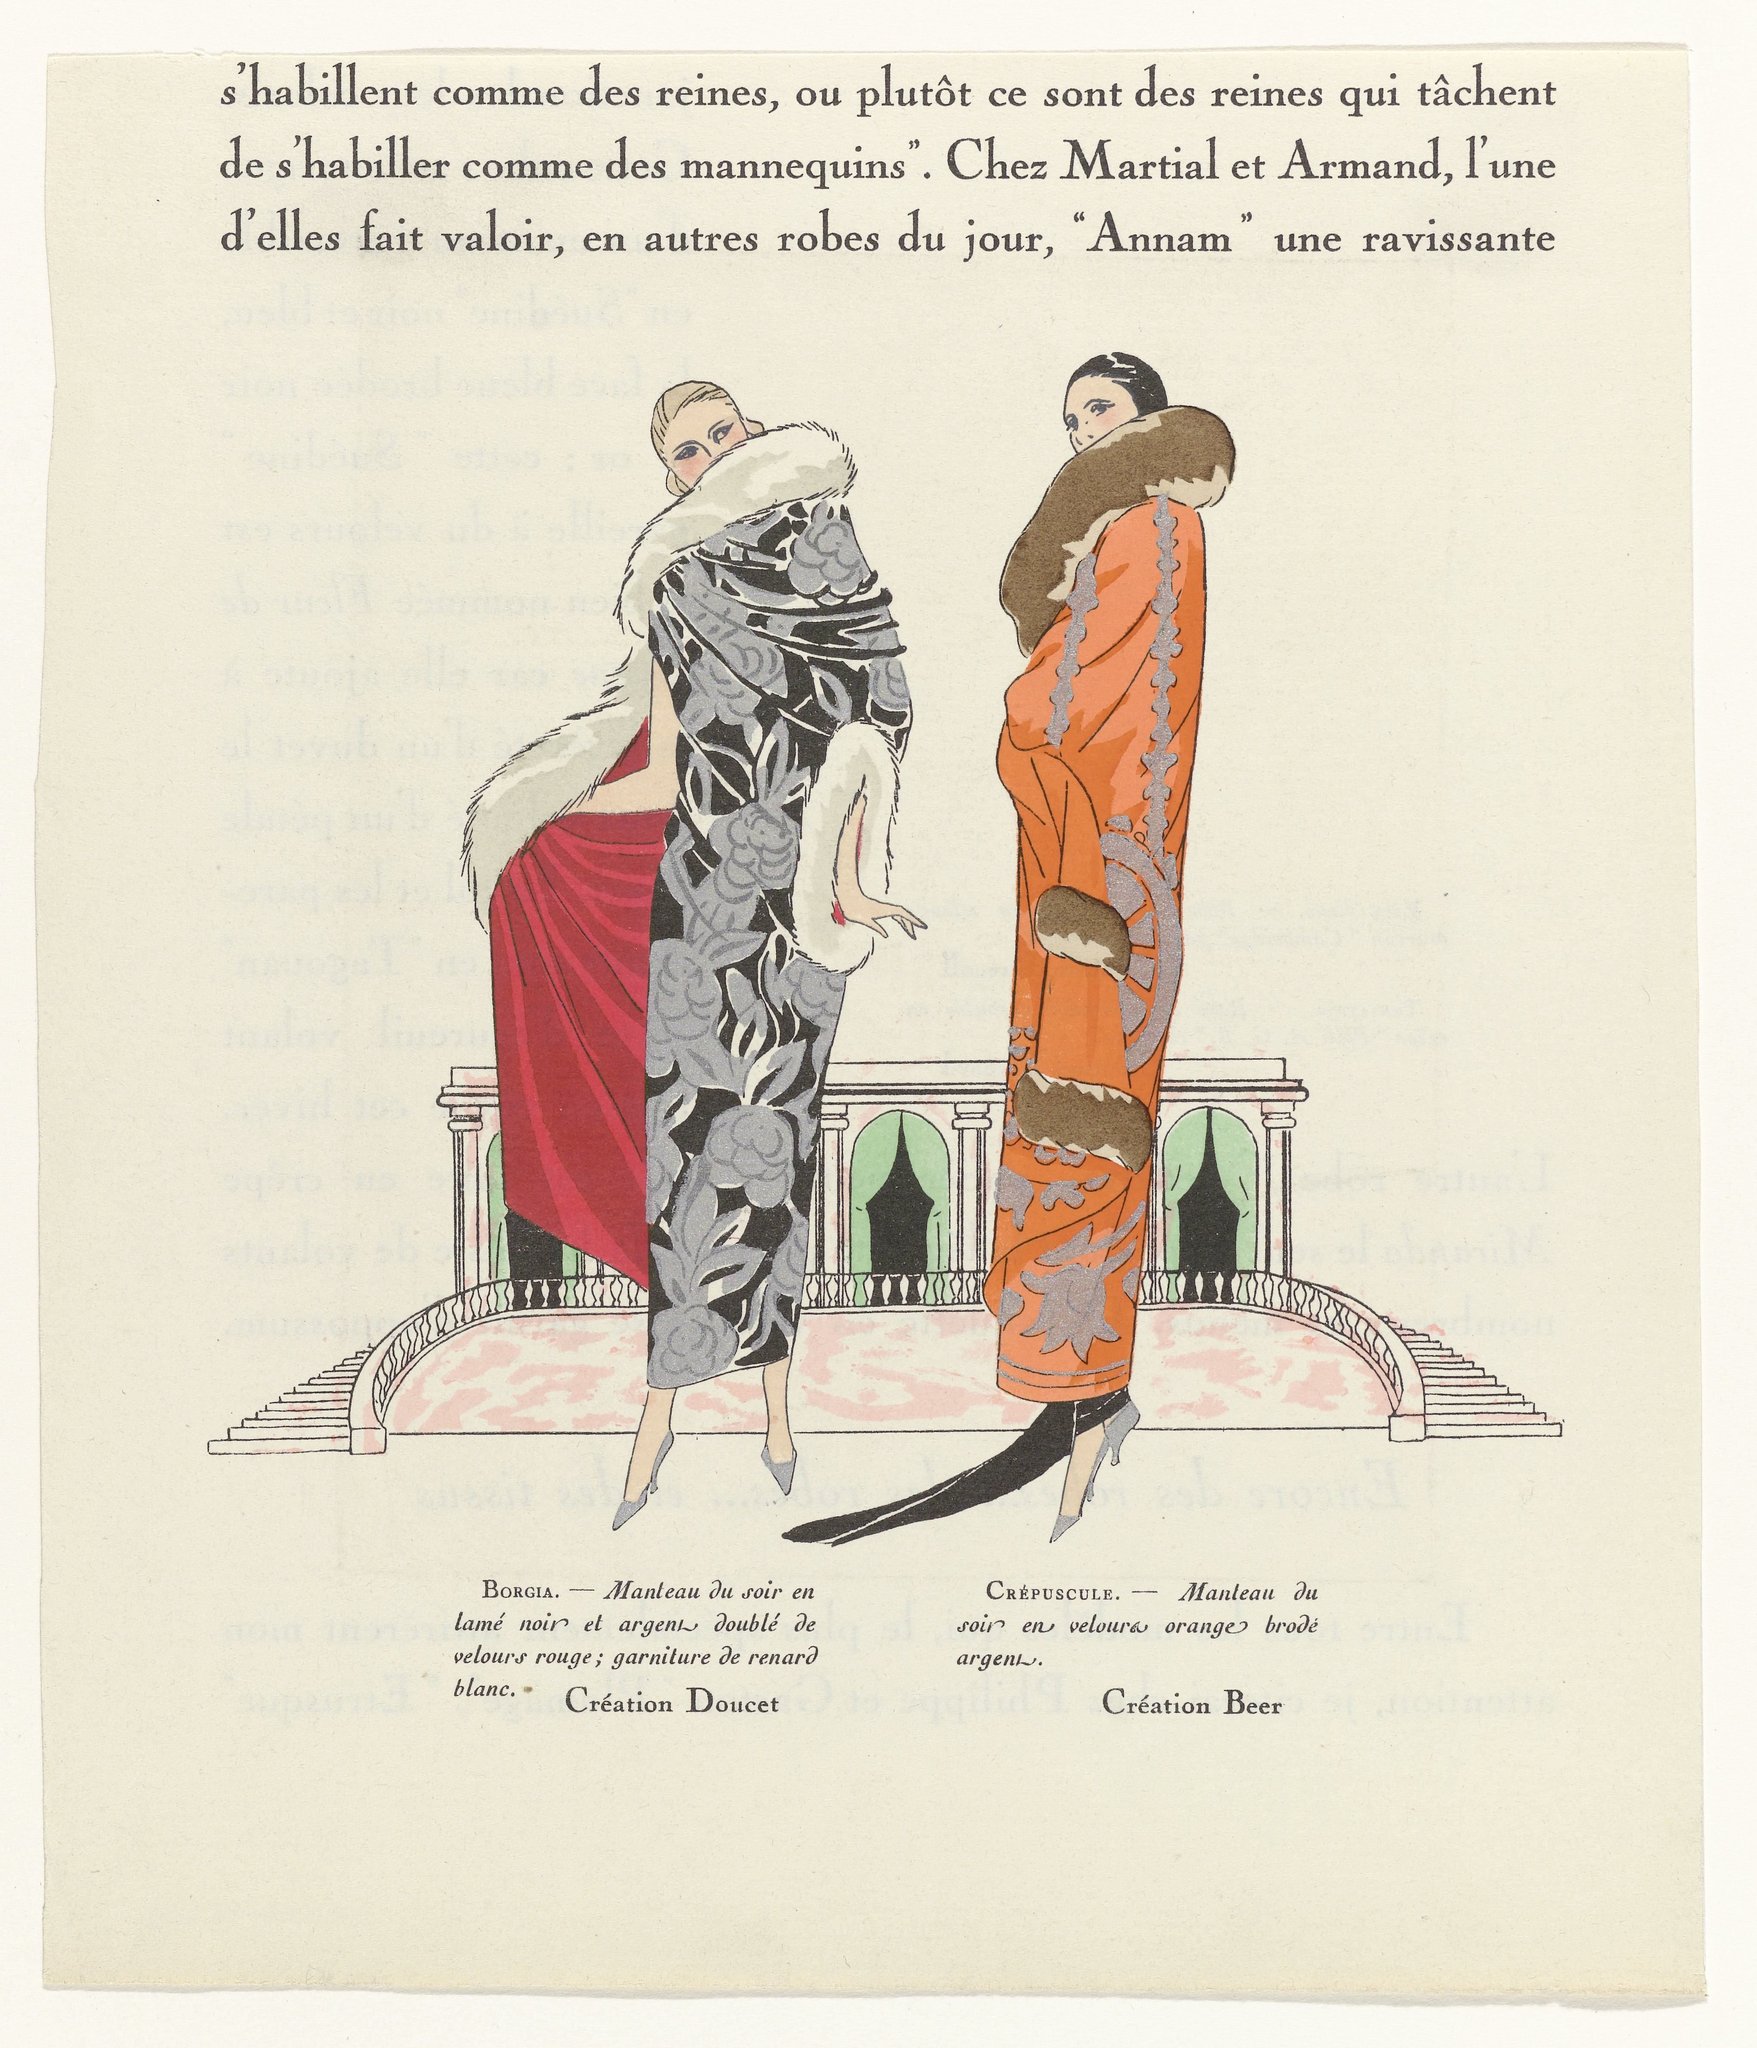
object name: fashion print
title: Art-Goût-Beauté, ca. 1924 : Borgia. - Manteau du soir (...)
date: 1924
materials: paper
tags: coat (evening coat) (+ fur used for clothes), coat (evening coat) (+ women's clothes), fashion plates, neck-gear: collar (+ fur used for clothes)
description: Twee vrouwen in avondmantels van Doucet en Beer, beide met grote bontkragen. Prent waarschijnlijk uit het modetijdschrift Art-Goût-Beauté (1920-1933).